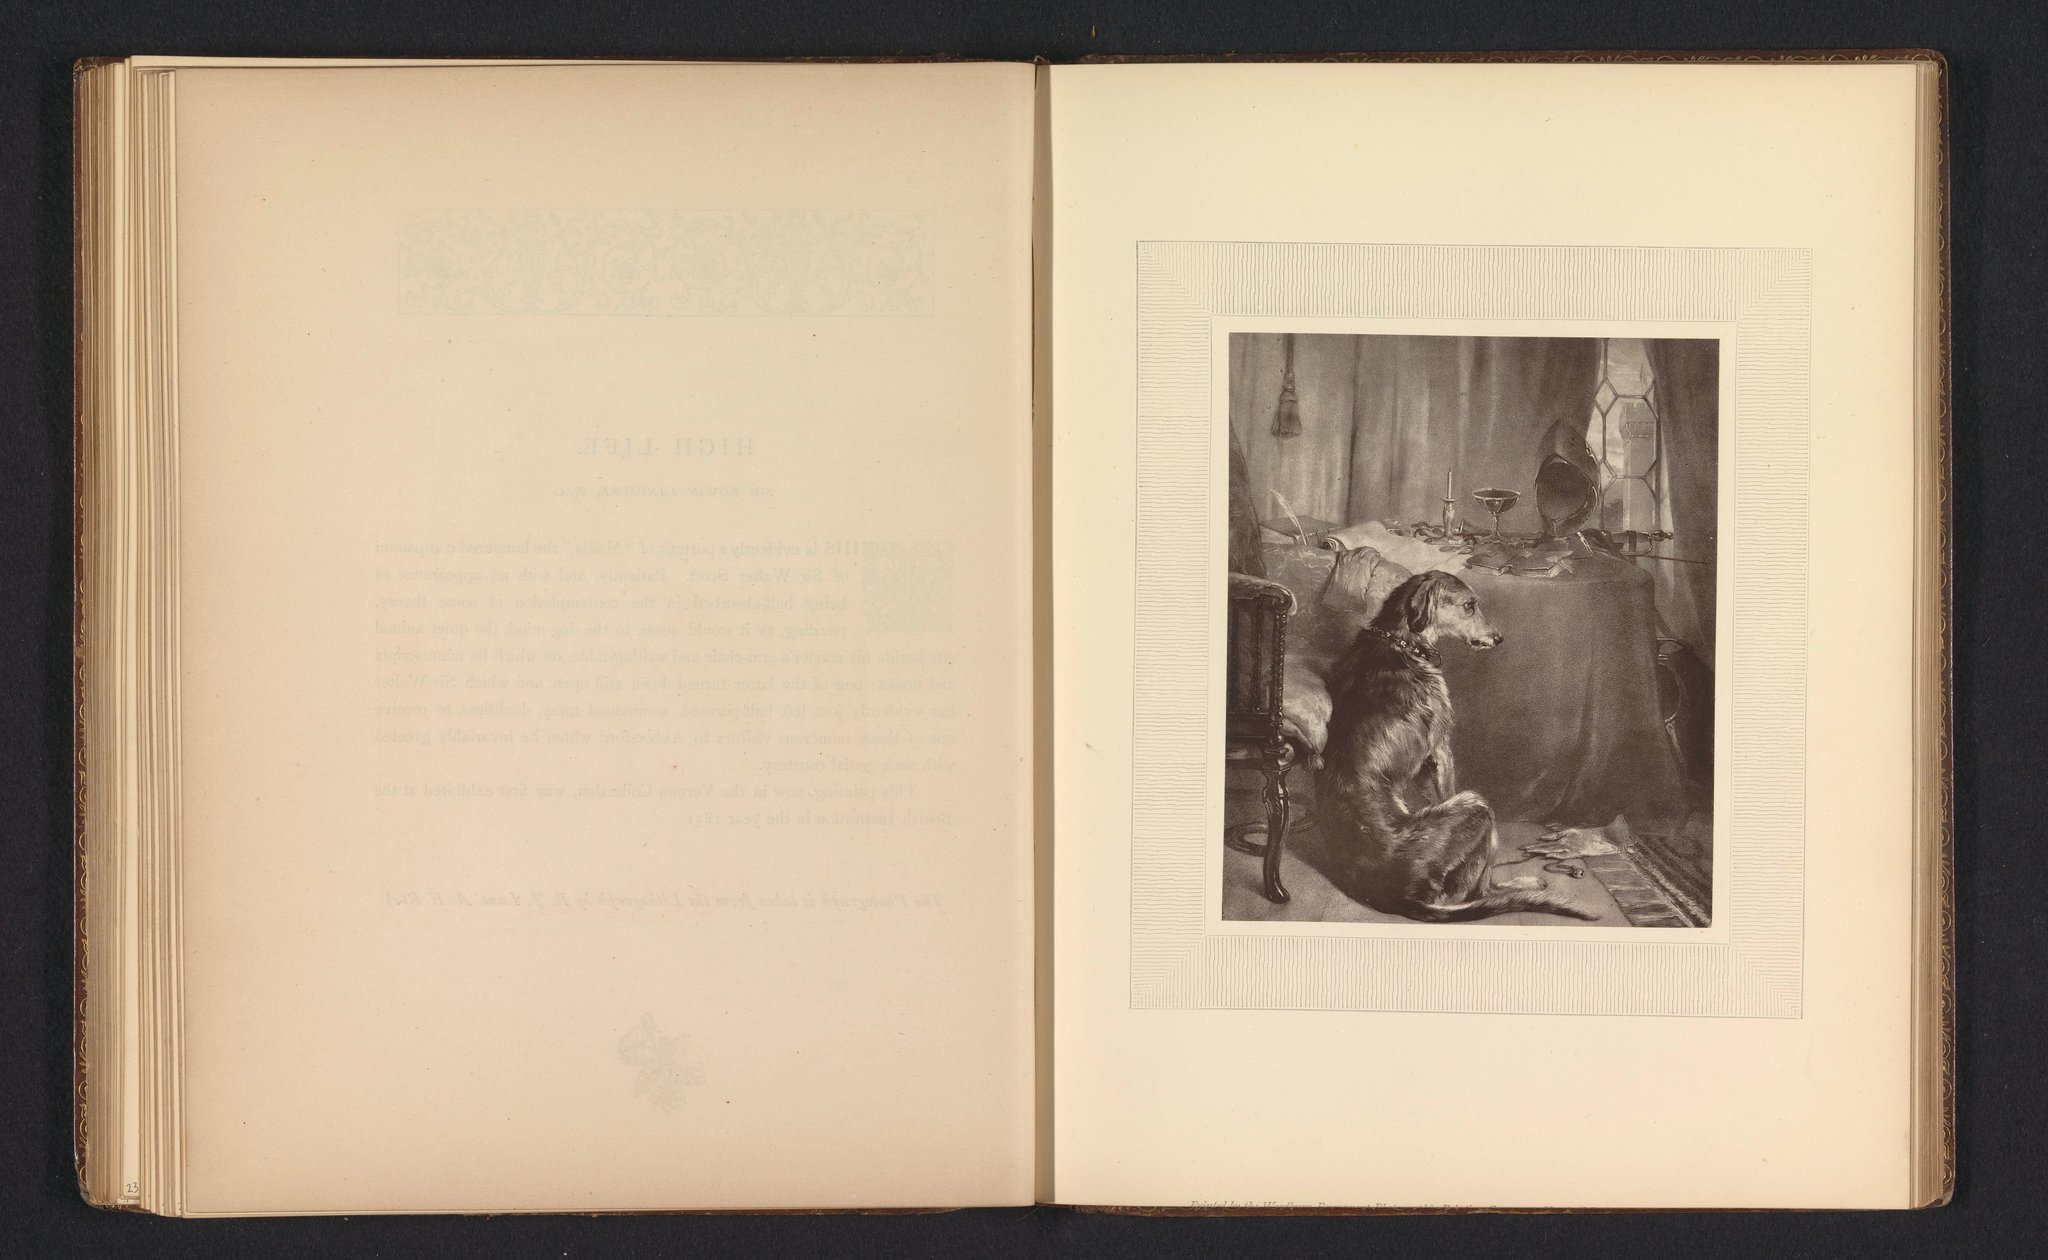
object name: photomechanical print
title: Fotoreproductie van een prent naar een schilderij met een hond voor een tafel door Edwin Henry Landseer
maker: Anonymous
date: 1864-1874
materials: paper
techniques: woodburytype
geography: london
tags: picture, painting, dog